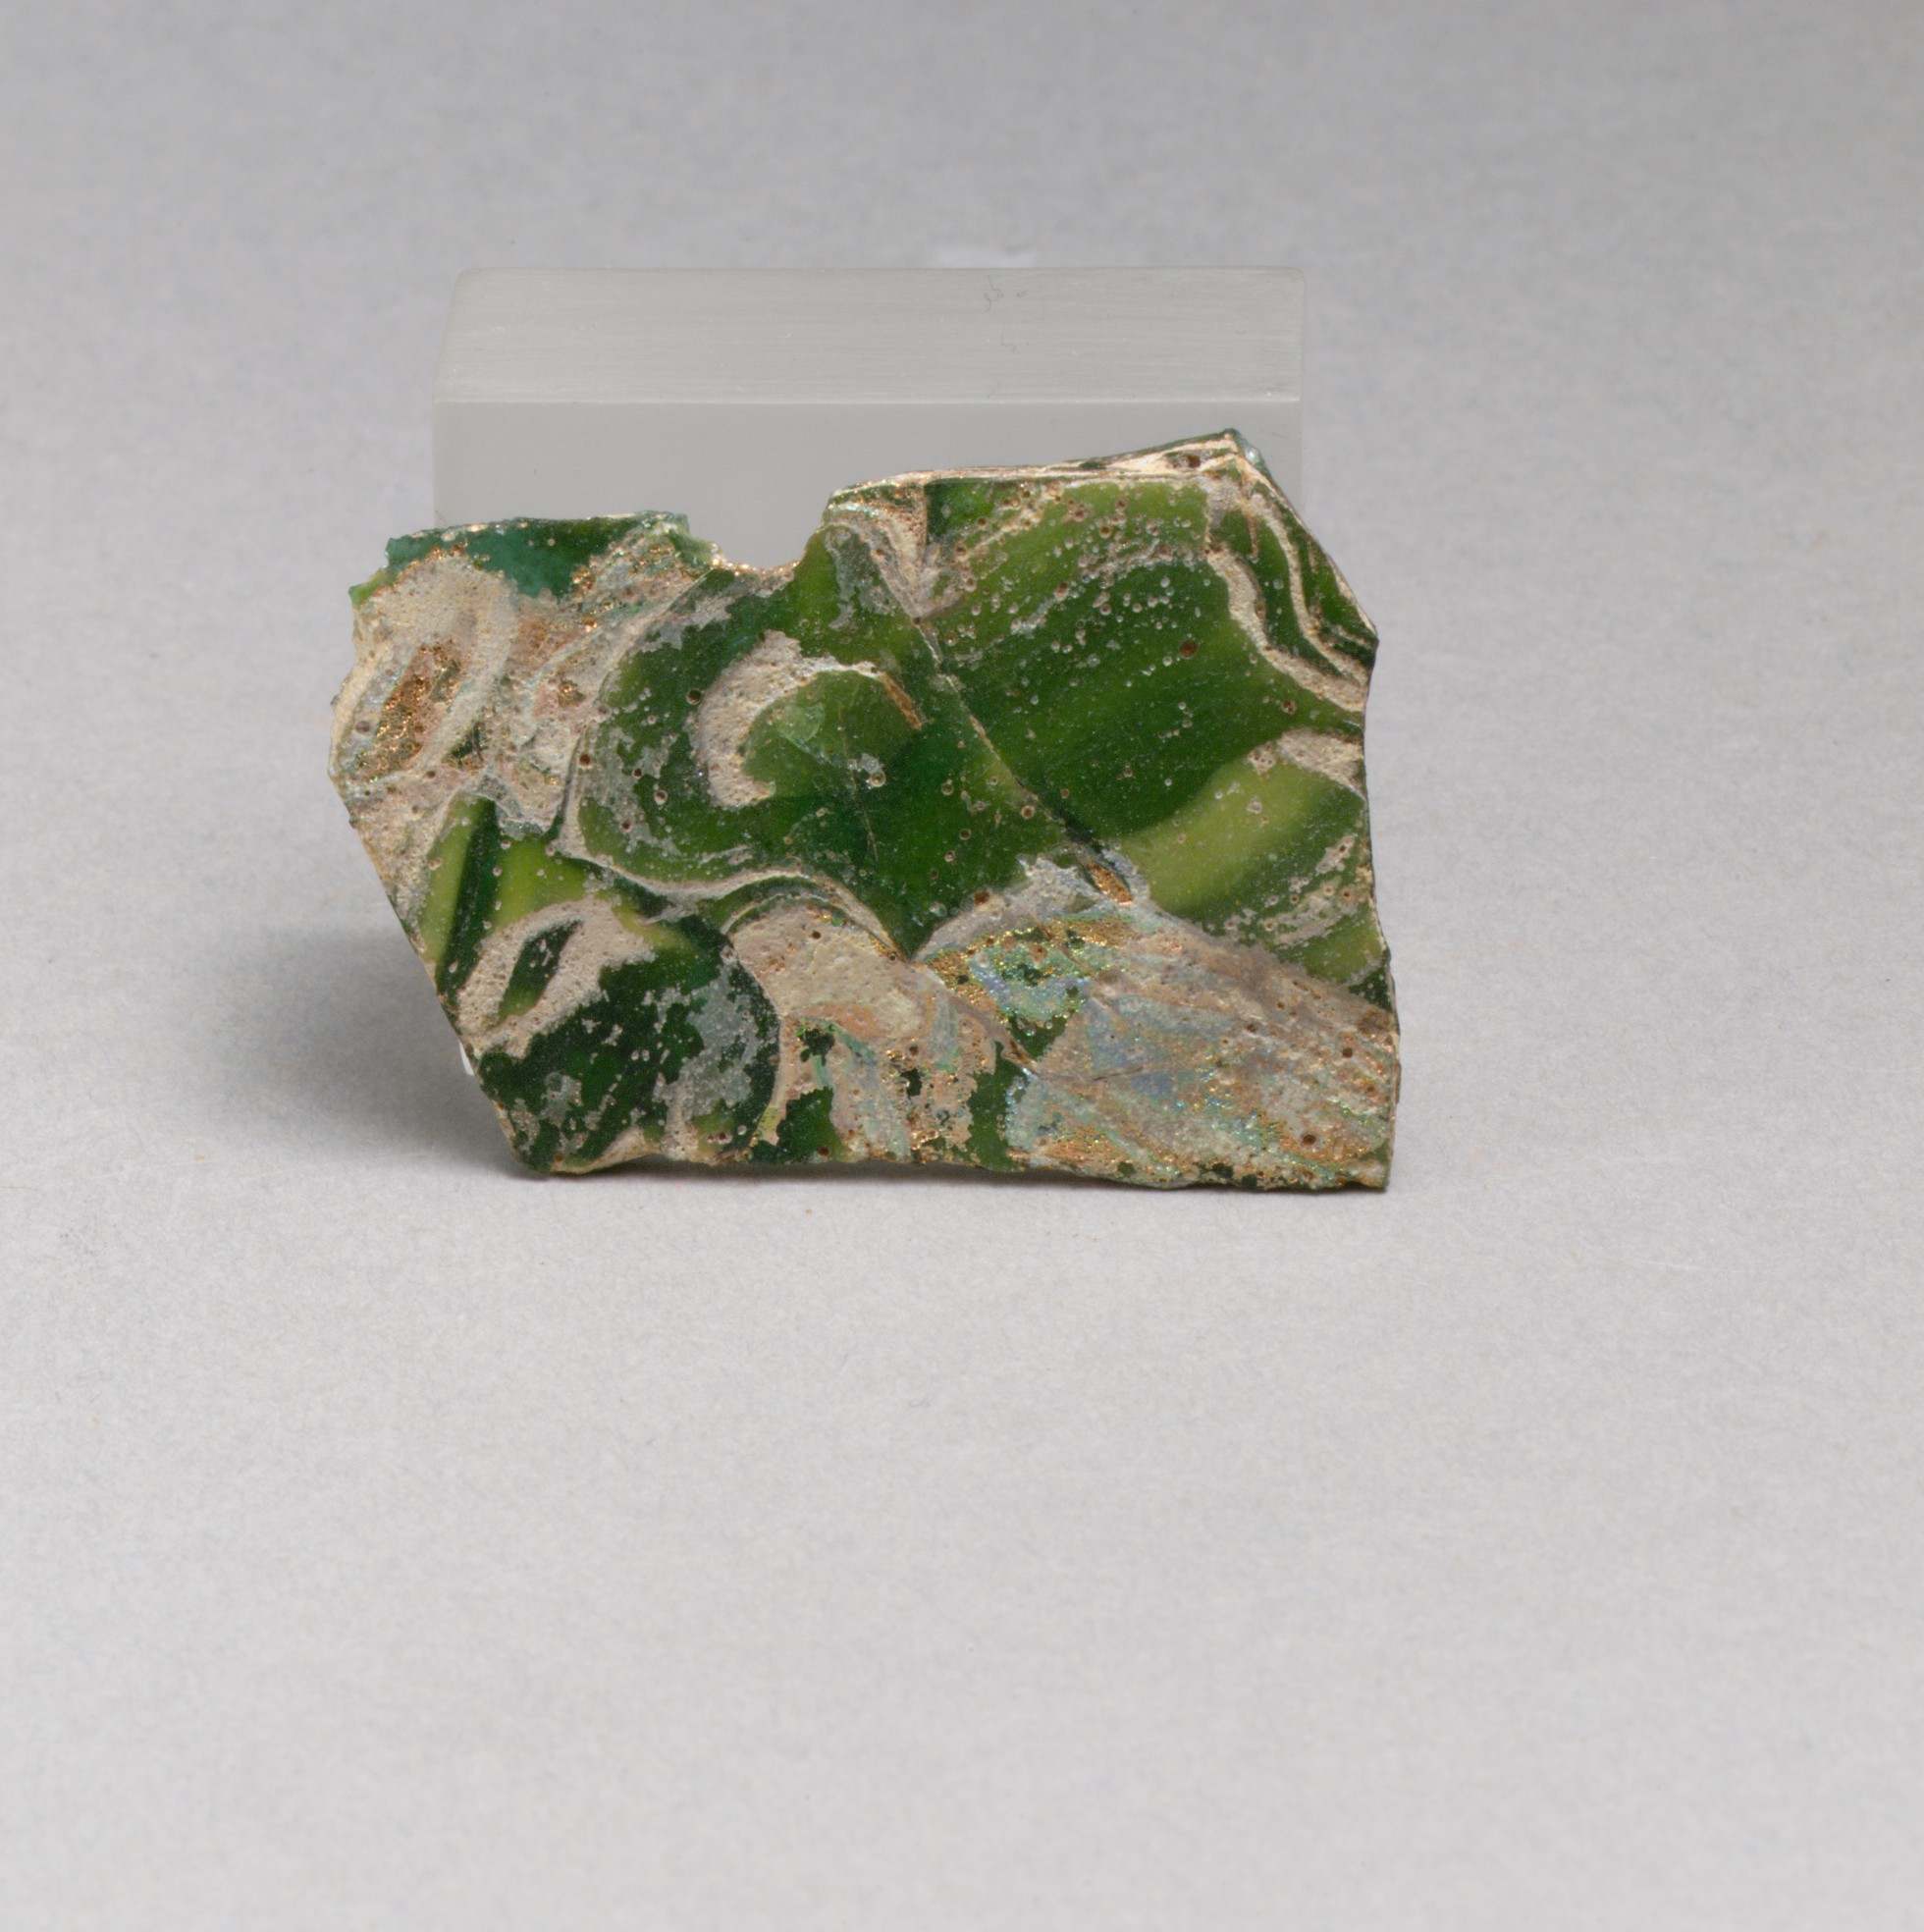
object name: fragment, mosaic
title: Glass mosaic inlay fragment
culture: roman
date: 34 BCE-33 CE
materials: glass